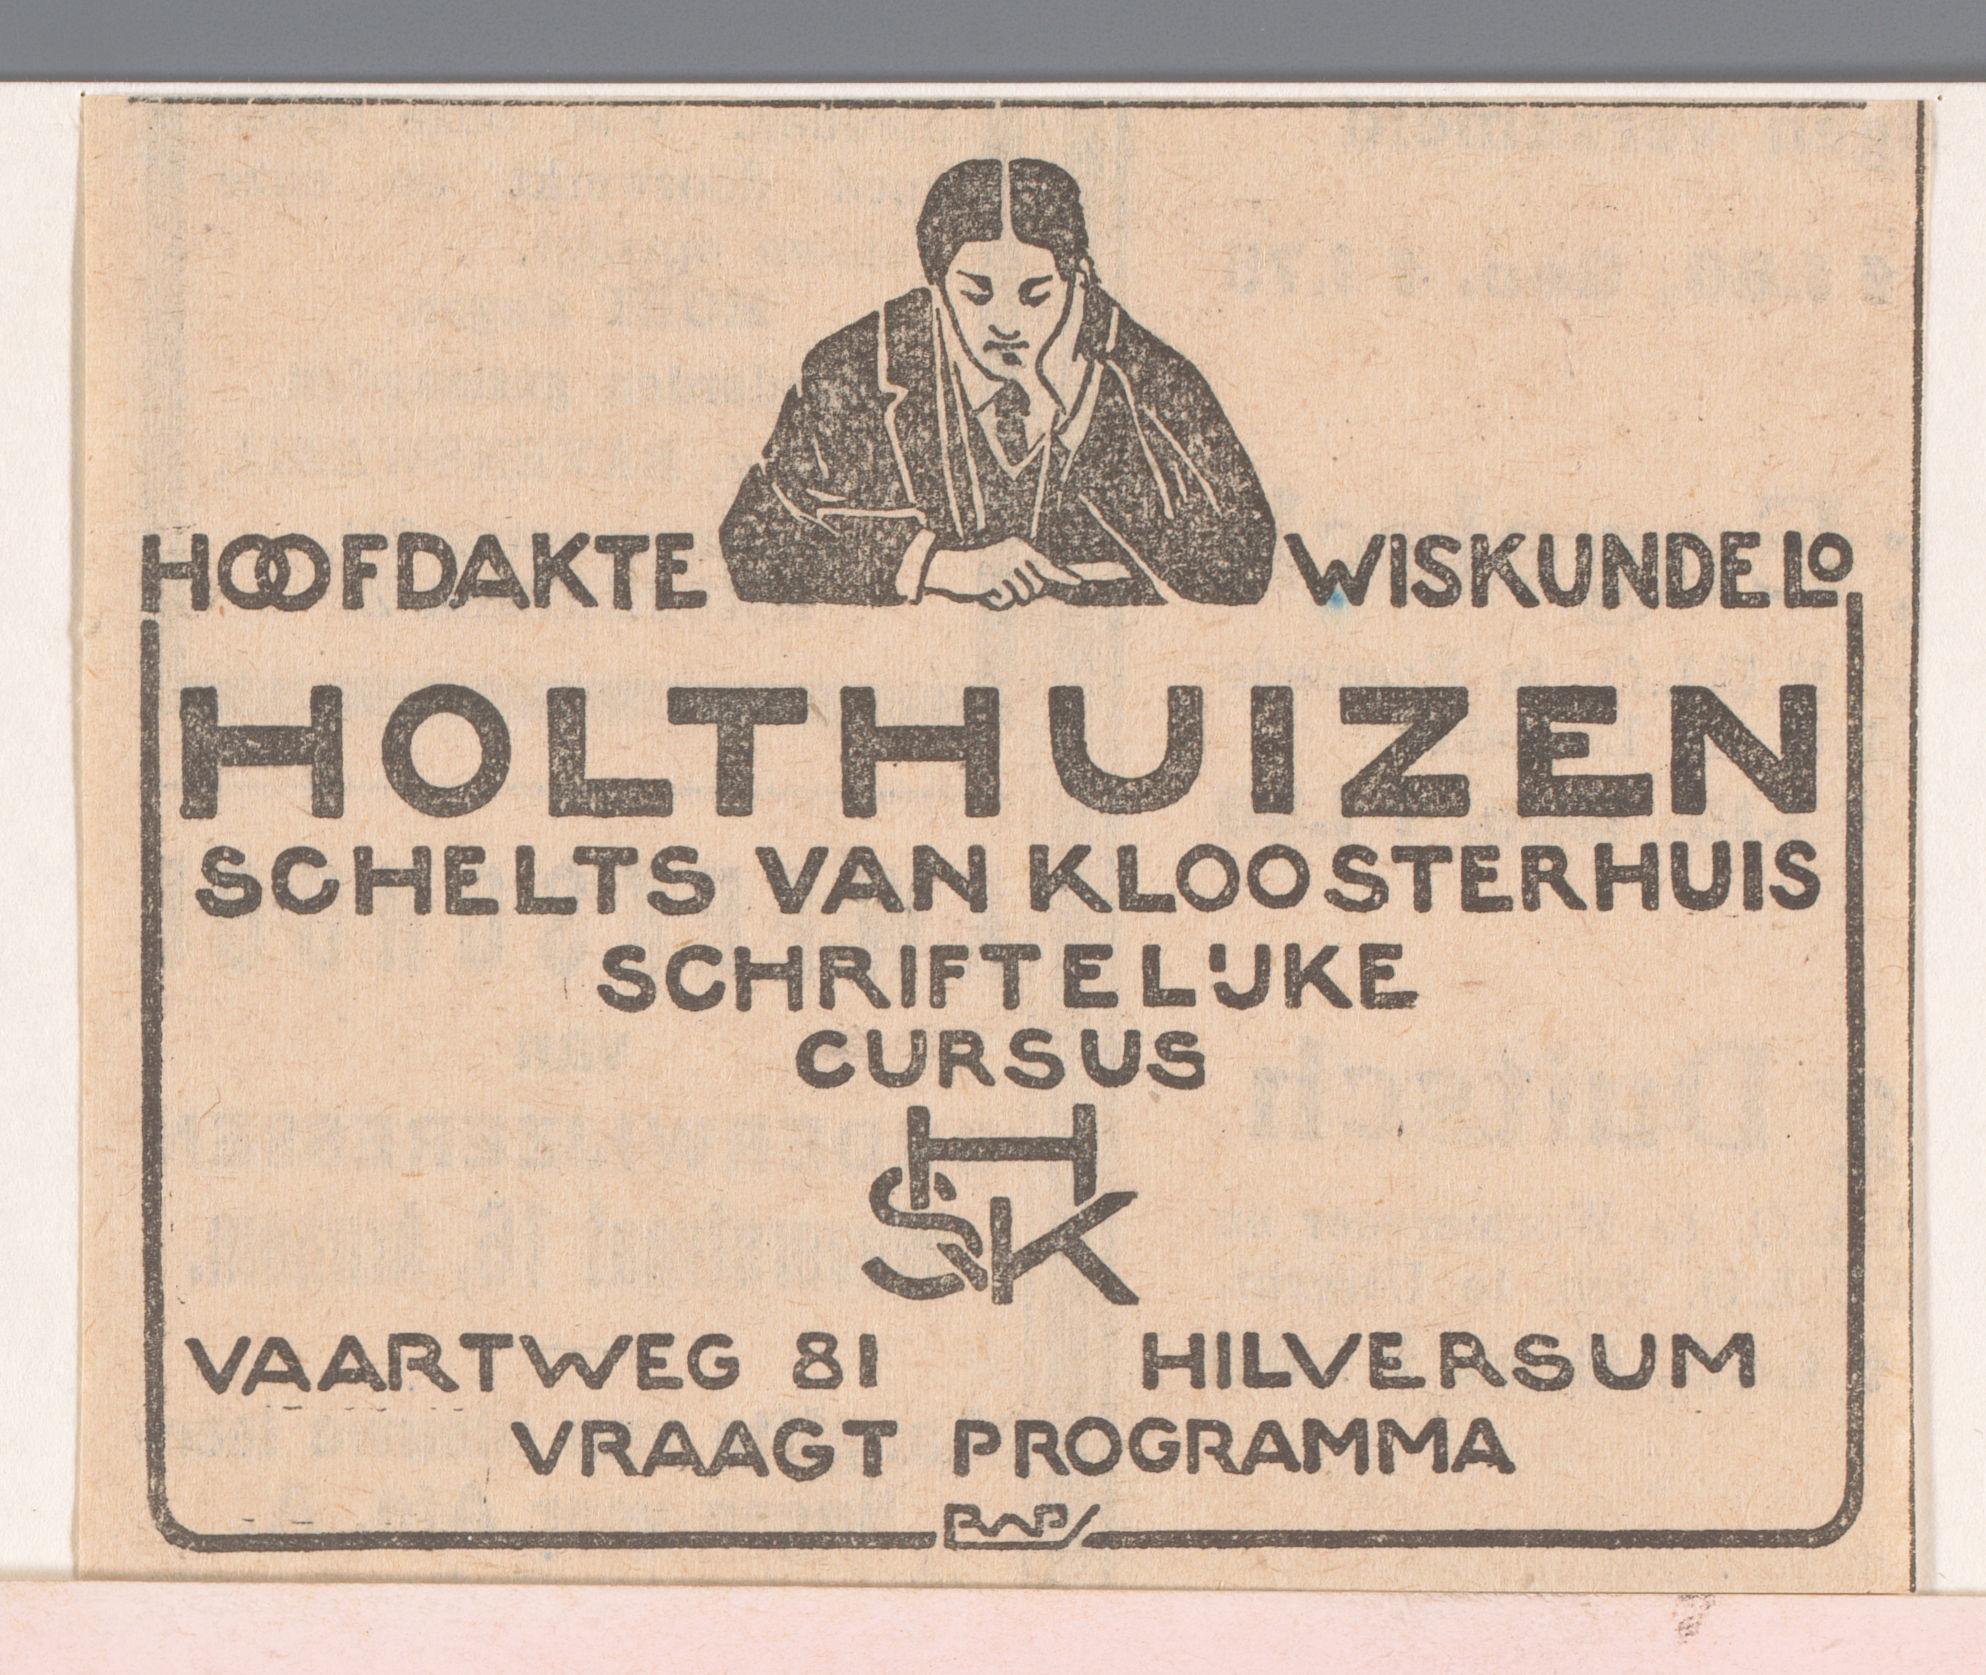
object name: print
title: Krantenadvertentie voor Cursus Holthuizen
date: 1884-1952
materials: paper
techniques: printing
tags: reading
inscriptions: collector's mark: ‘R:MVS.’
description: Krantenadvertentie met een lezende man die zijn hoofd ondersteunt met zijn hand.